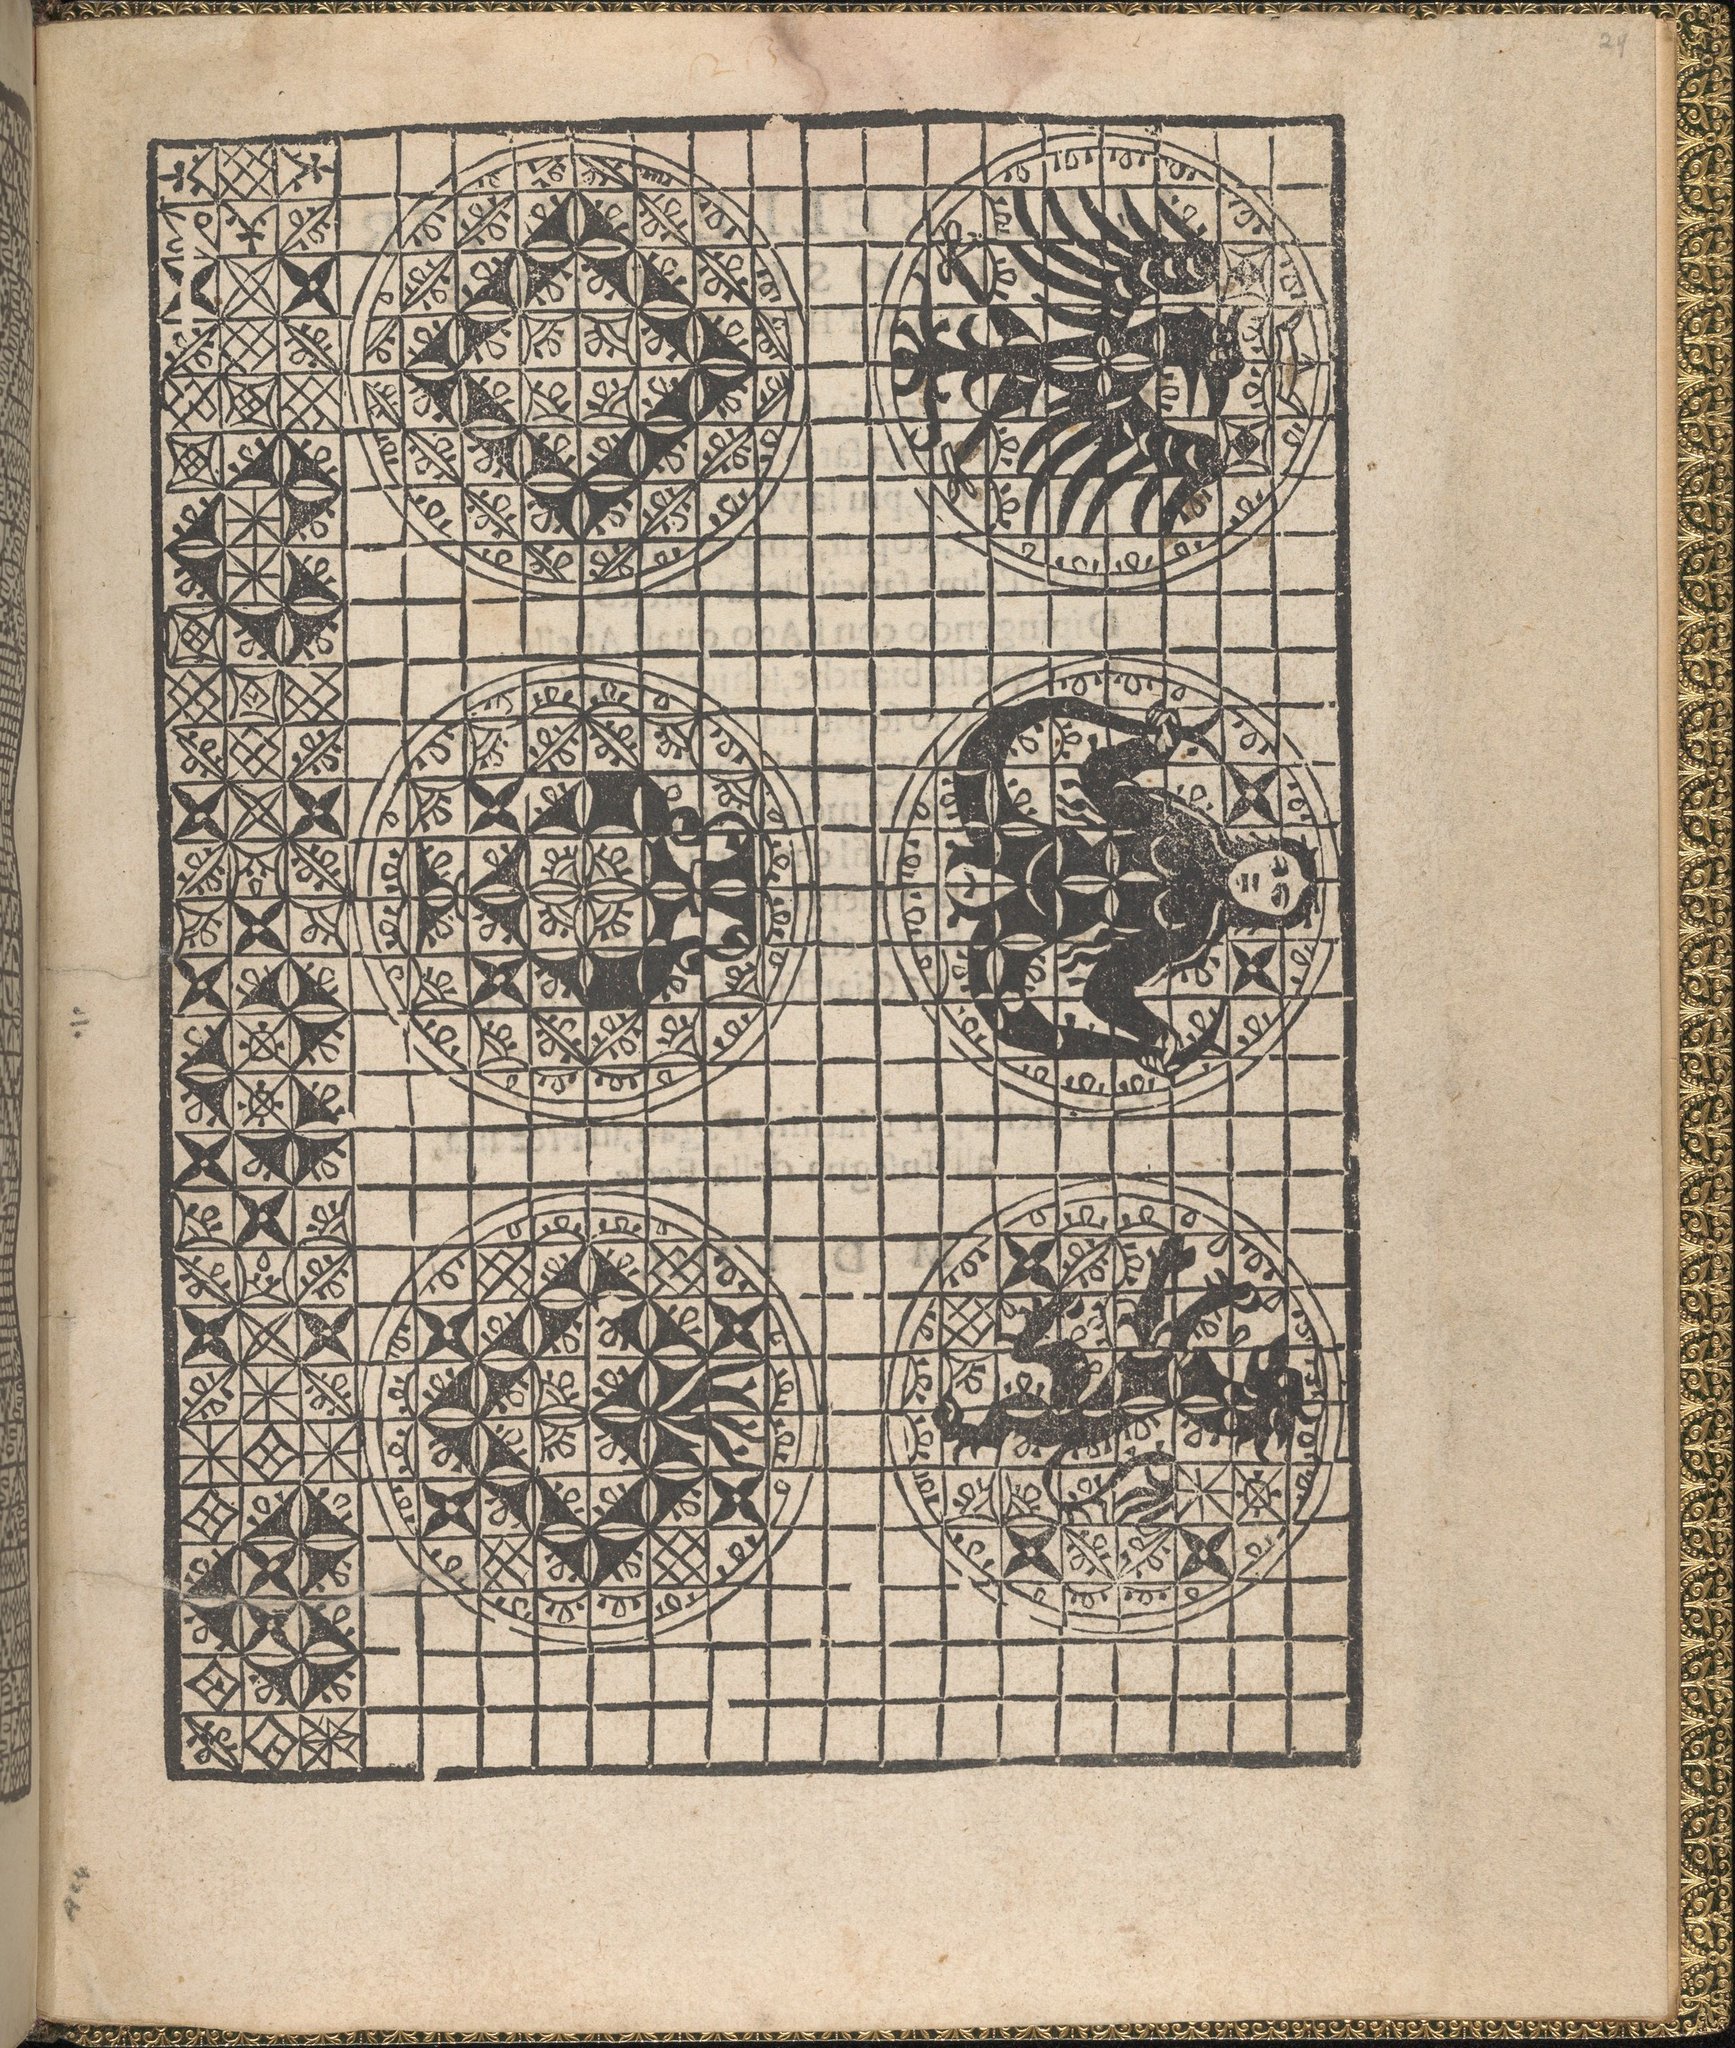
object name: book print ornament architecture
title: Giardineto novo di punti tagliati et gropposi per exercitio & ornamento delle donne (Venice 1554), page 24 (recto)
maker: matteo pagano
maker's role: publisher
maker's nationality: italian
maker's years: 1515-1588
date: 1554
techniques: woodcut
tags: ornament